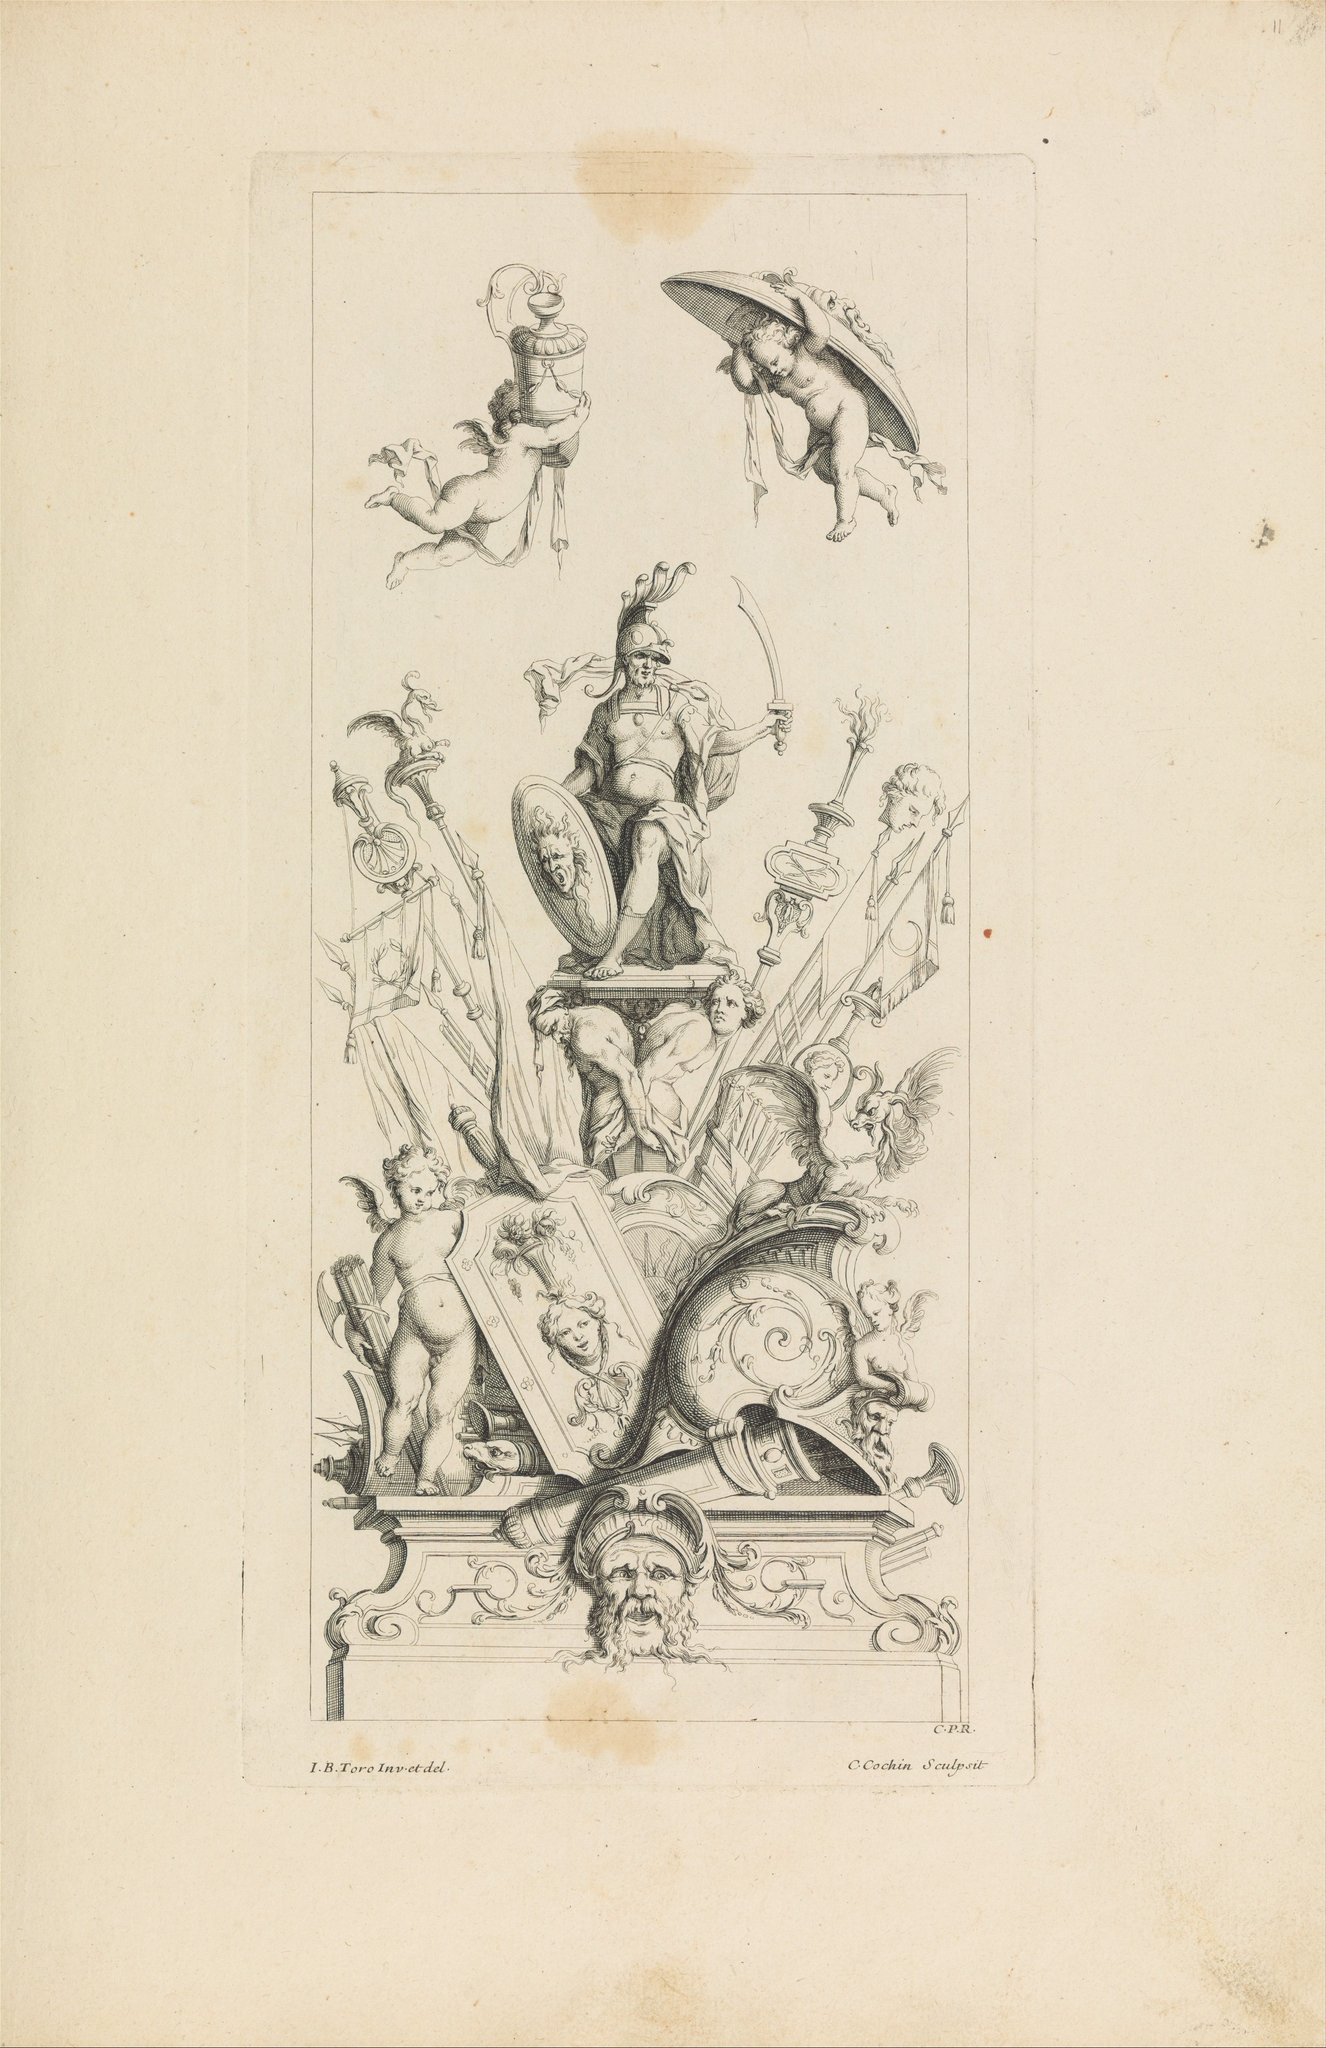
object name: album print ornament architecture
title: Trophées Nouvellement Inventez par J.B. Toro.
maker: jean bernard toro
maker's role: designer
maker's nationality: french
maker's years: 1672-1731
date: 1716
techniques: etching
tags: ornament,men,putti,trophies